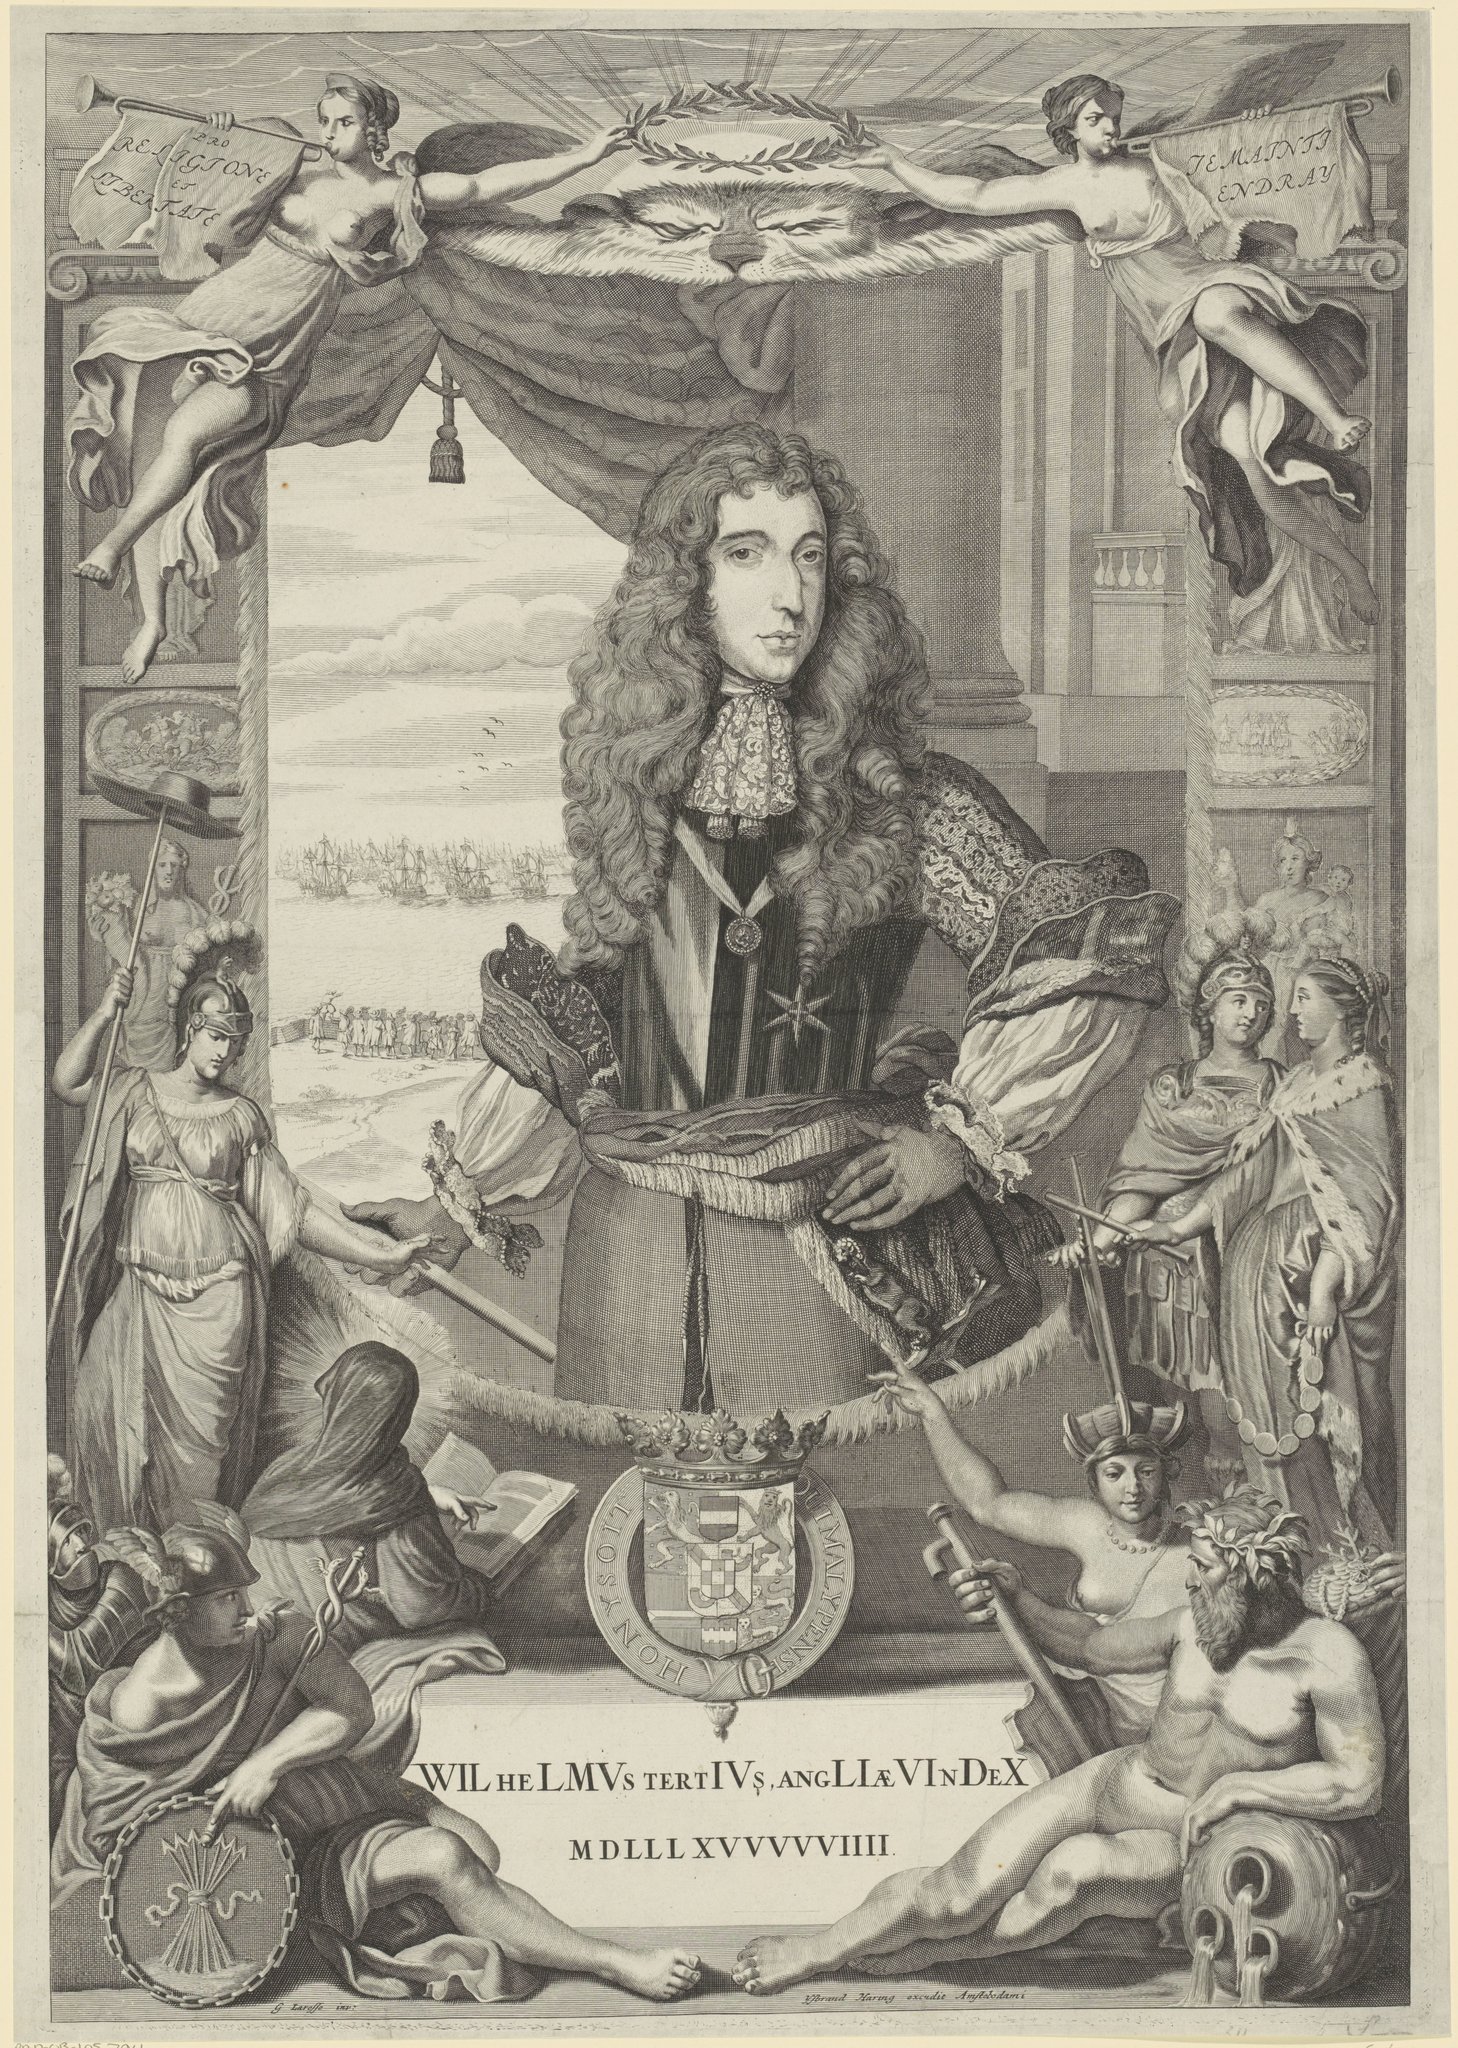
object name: print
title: Portret van Willem III, prins van Oranje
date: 1689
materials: paper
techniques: engraving, etching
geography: amsterdam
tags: the hague, william iii (prince of orange and king of england, scotland, and ireland), knighthood order (garter) - insignia of a knighthood order, e.g.: badge, chain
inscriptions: collector's mark: Lugt 963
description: Portret van Willem III. In zijn rechterhand een commandostaf. Twee allegorische figuren met bazuinen houden een lauwerkrans boven zijn hoofd. Links en rechts een aantal allegorische objecten en figuren. Op de achtergrond een vloot. Midden onder zijn wapen met een kroon, gedecoreerd met de Kousenband en het devies van de Orde van de Kousenband. In een kader twee regels Latijnse tekst.